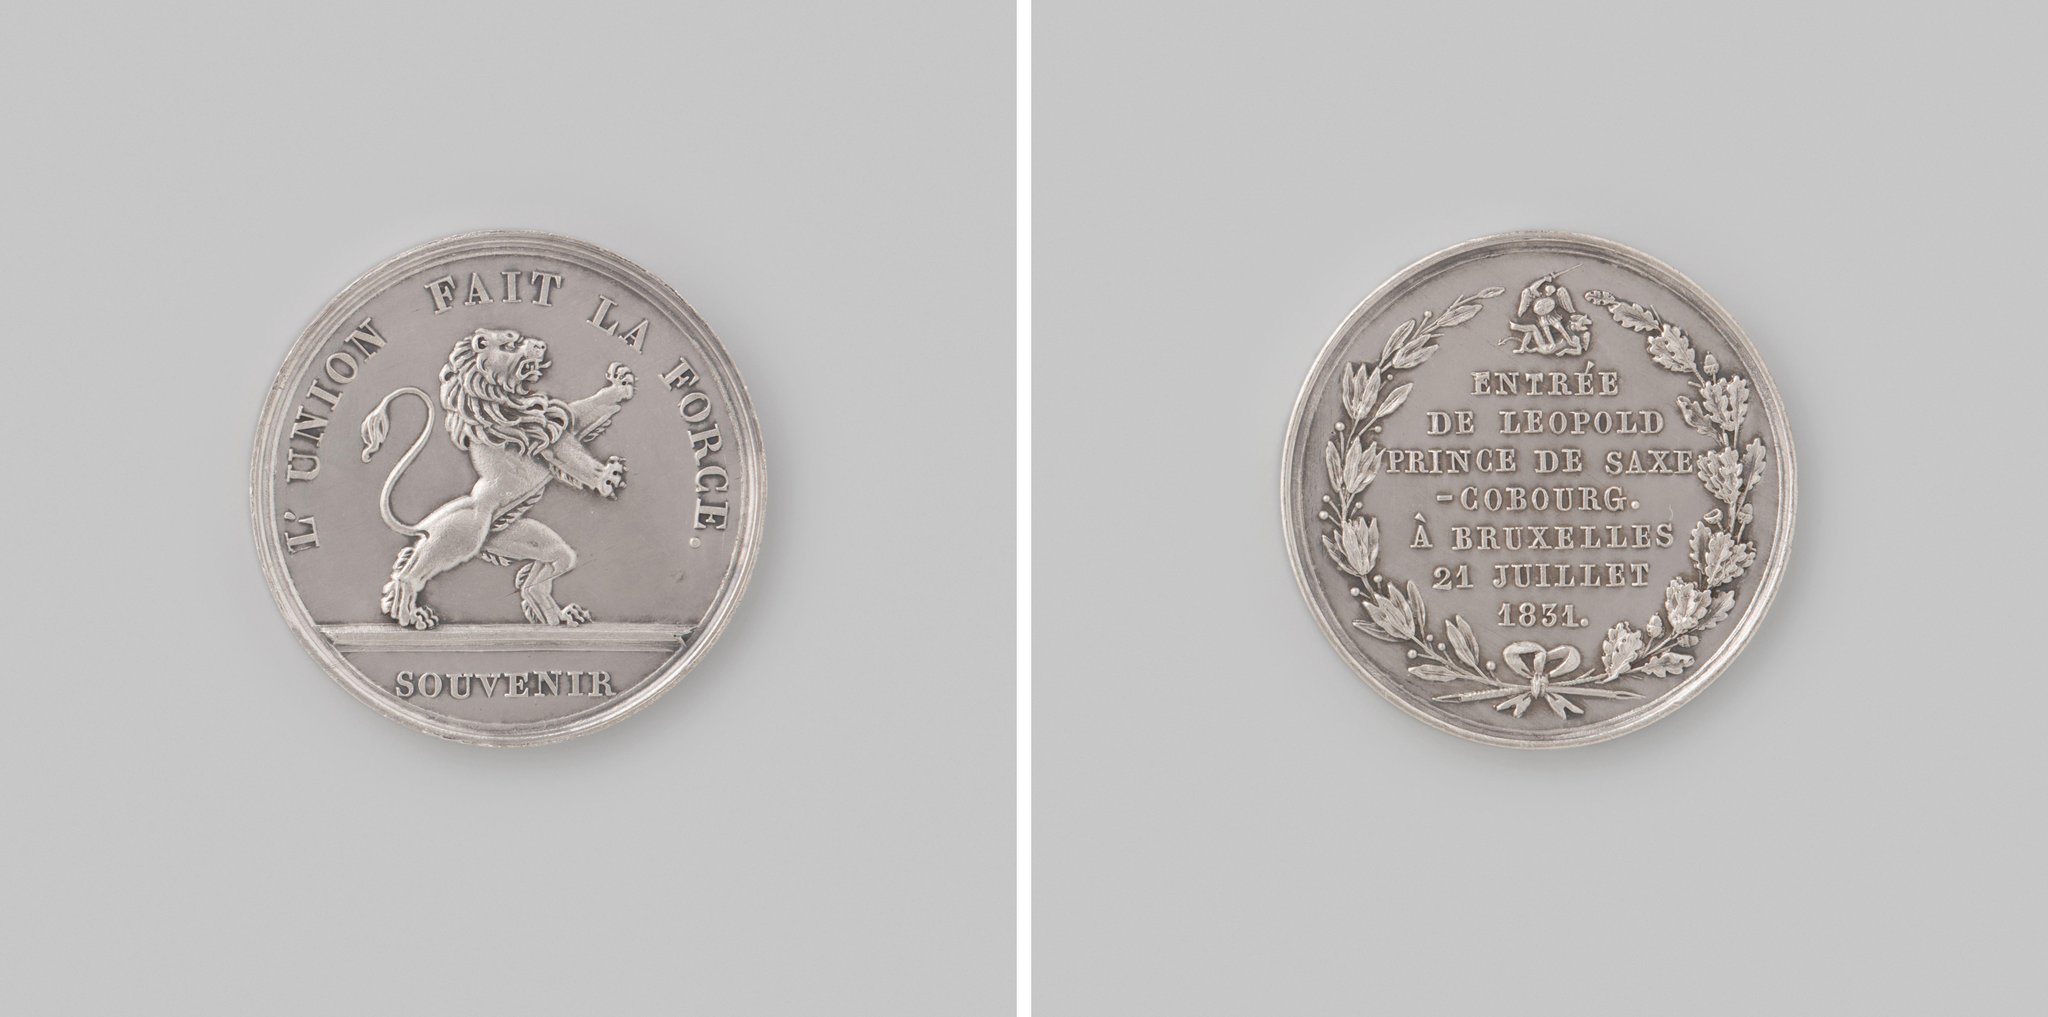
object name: strooipenning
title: Intocht van Leopold van Saksen-Coburg te Brussel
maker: joseph pierre braemt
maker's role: print maker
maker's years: 1796-1864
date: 1831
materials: silver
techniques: striking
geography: brussels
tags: laeken, leopold i (koning der belgen), brussels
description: Zilveren penning. Voorzijde: staande leeuw binnen omschrift; afsnede: opschrift. Keerzijde: opschrift onderbeeldje van St. Michael binnen tot krans samengebonden olijf- en eikentak